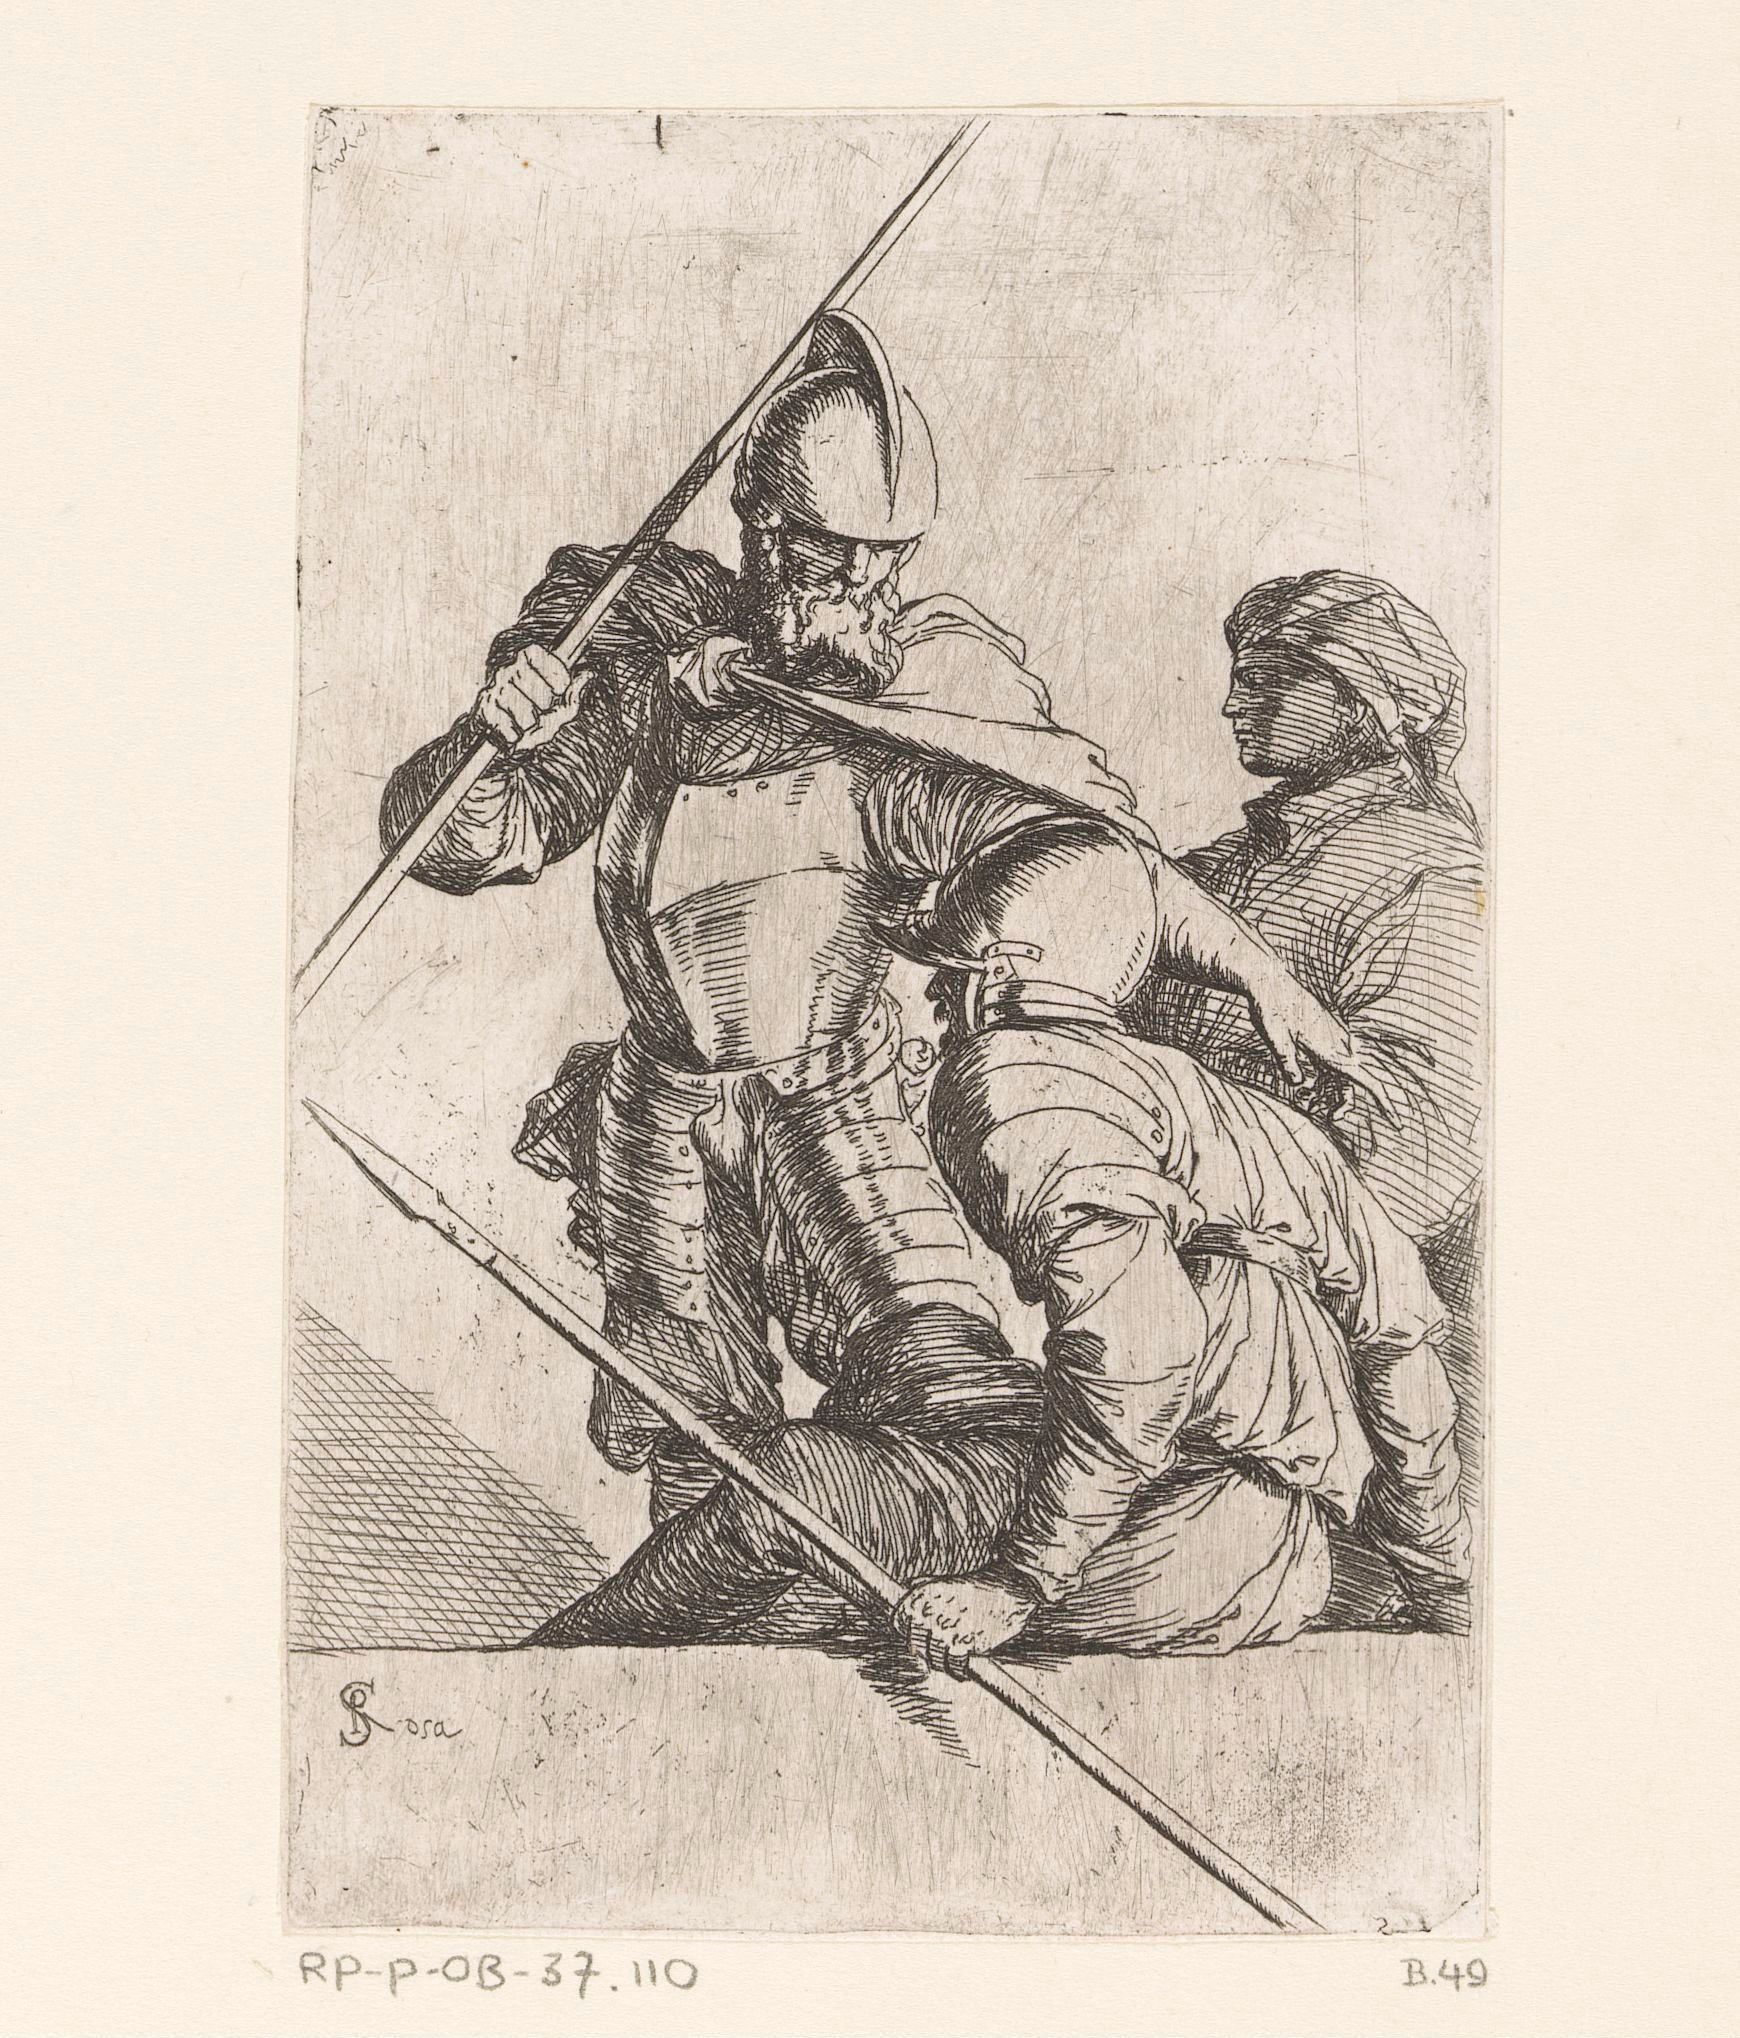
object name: print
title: Twee soldaten en een figuur met tulband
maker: salvator rosa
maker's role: draughtsman, painter, print maker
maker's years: 1615-1673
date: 1656-1657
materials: paper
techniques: etching, intaglio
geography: italy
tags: armour, helved weapons, polearms (for striking, hacking, thrusting): lance, head-gear: turban, the soldier; the soldier's life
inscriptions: collector's mark: Lugt 240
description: Deze prent maakt deel uit van de serie 'Figurine', bestaande uit een titelprent en 80 prenten van klein formaat met voorstellingen van mannelijke en vrouwelijke figuren. Rosa produceerde de serie waarschijnlijk gedurende de jaren 1656 en 1657.